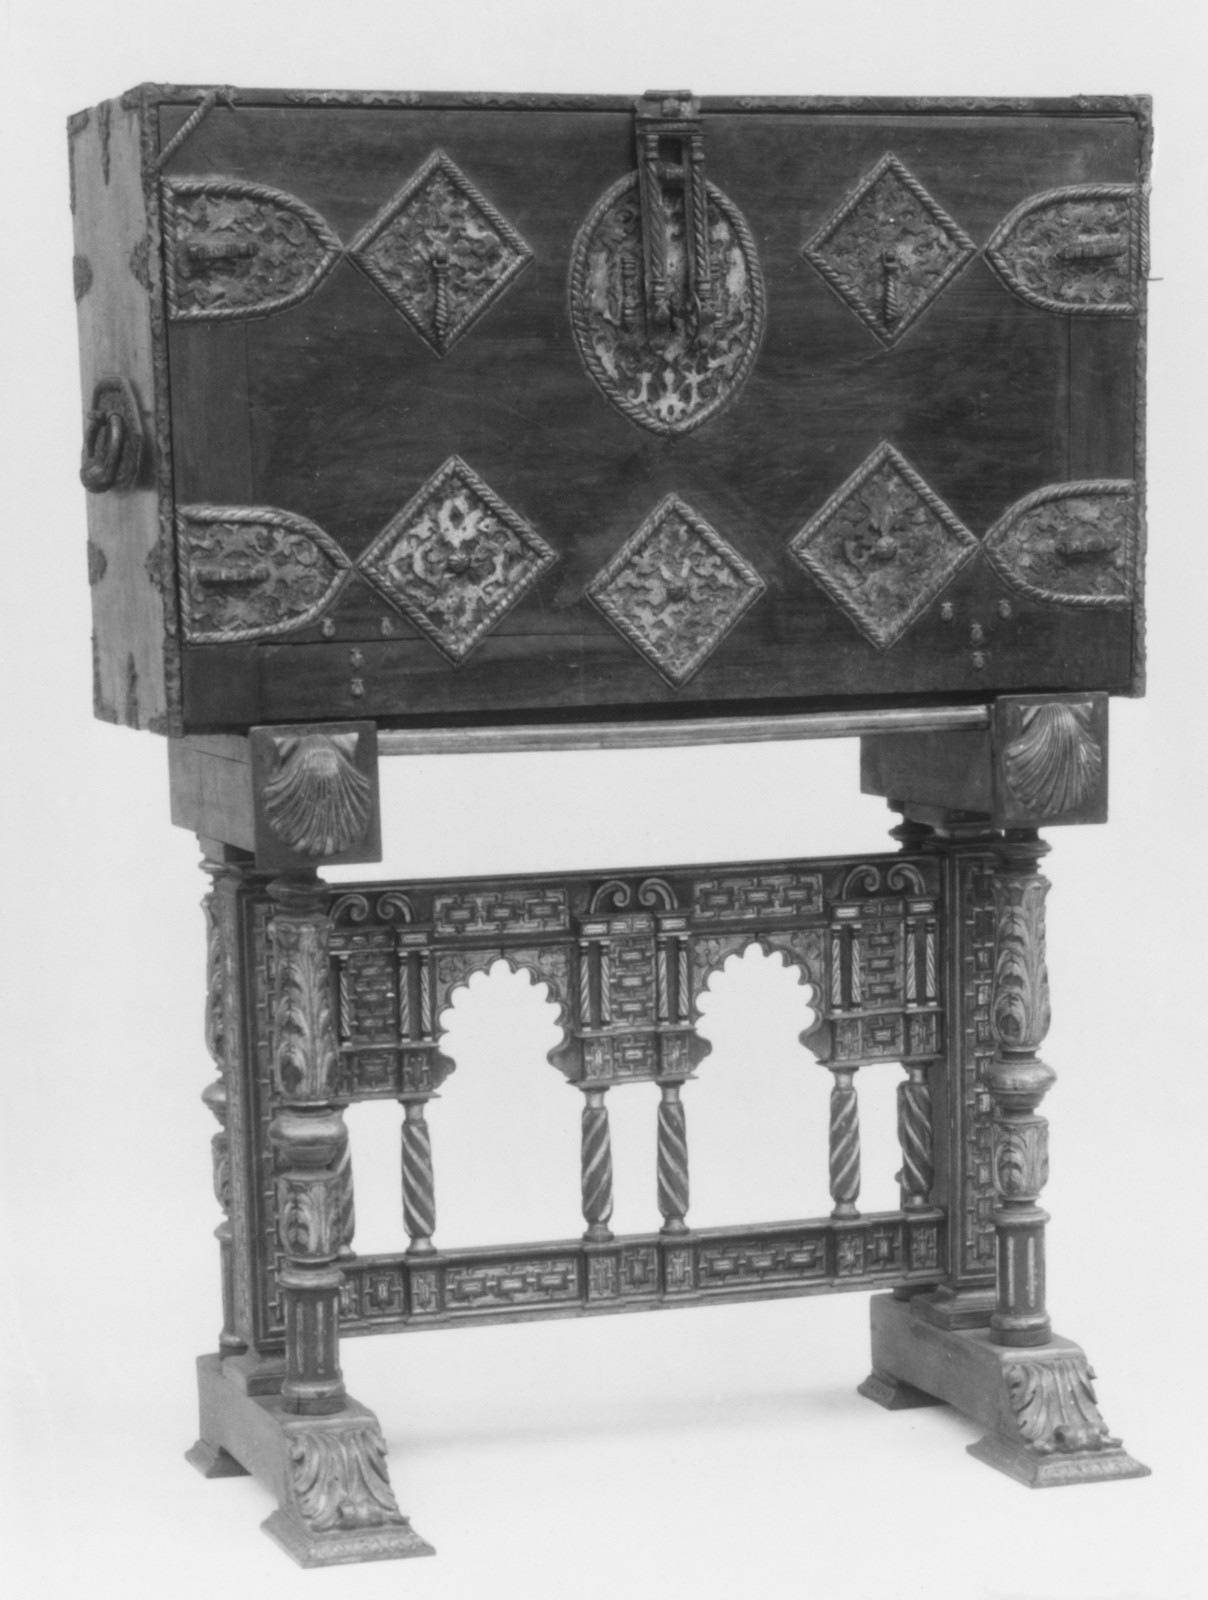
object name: vargueño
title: Vargueño (Scrutoire)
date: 1601-1700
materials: wood